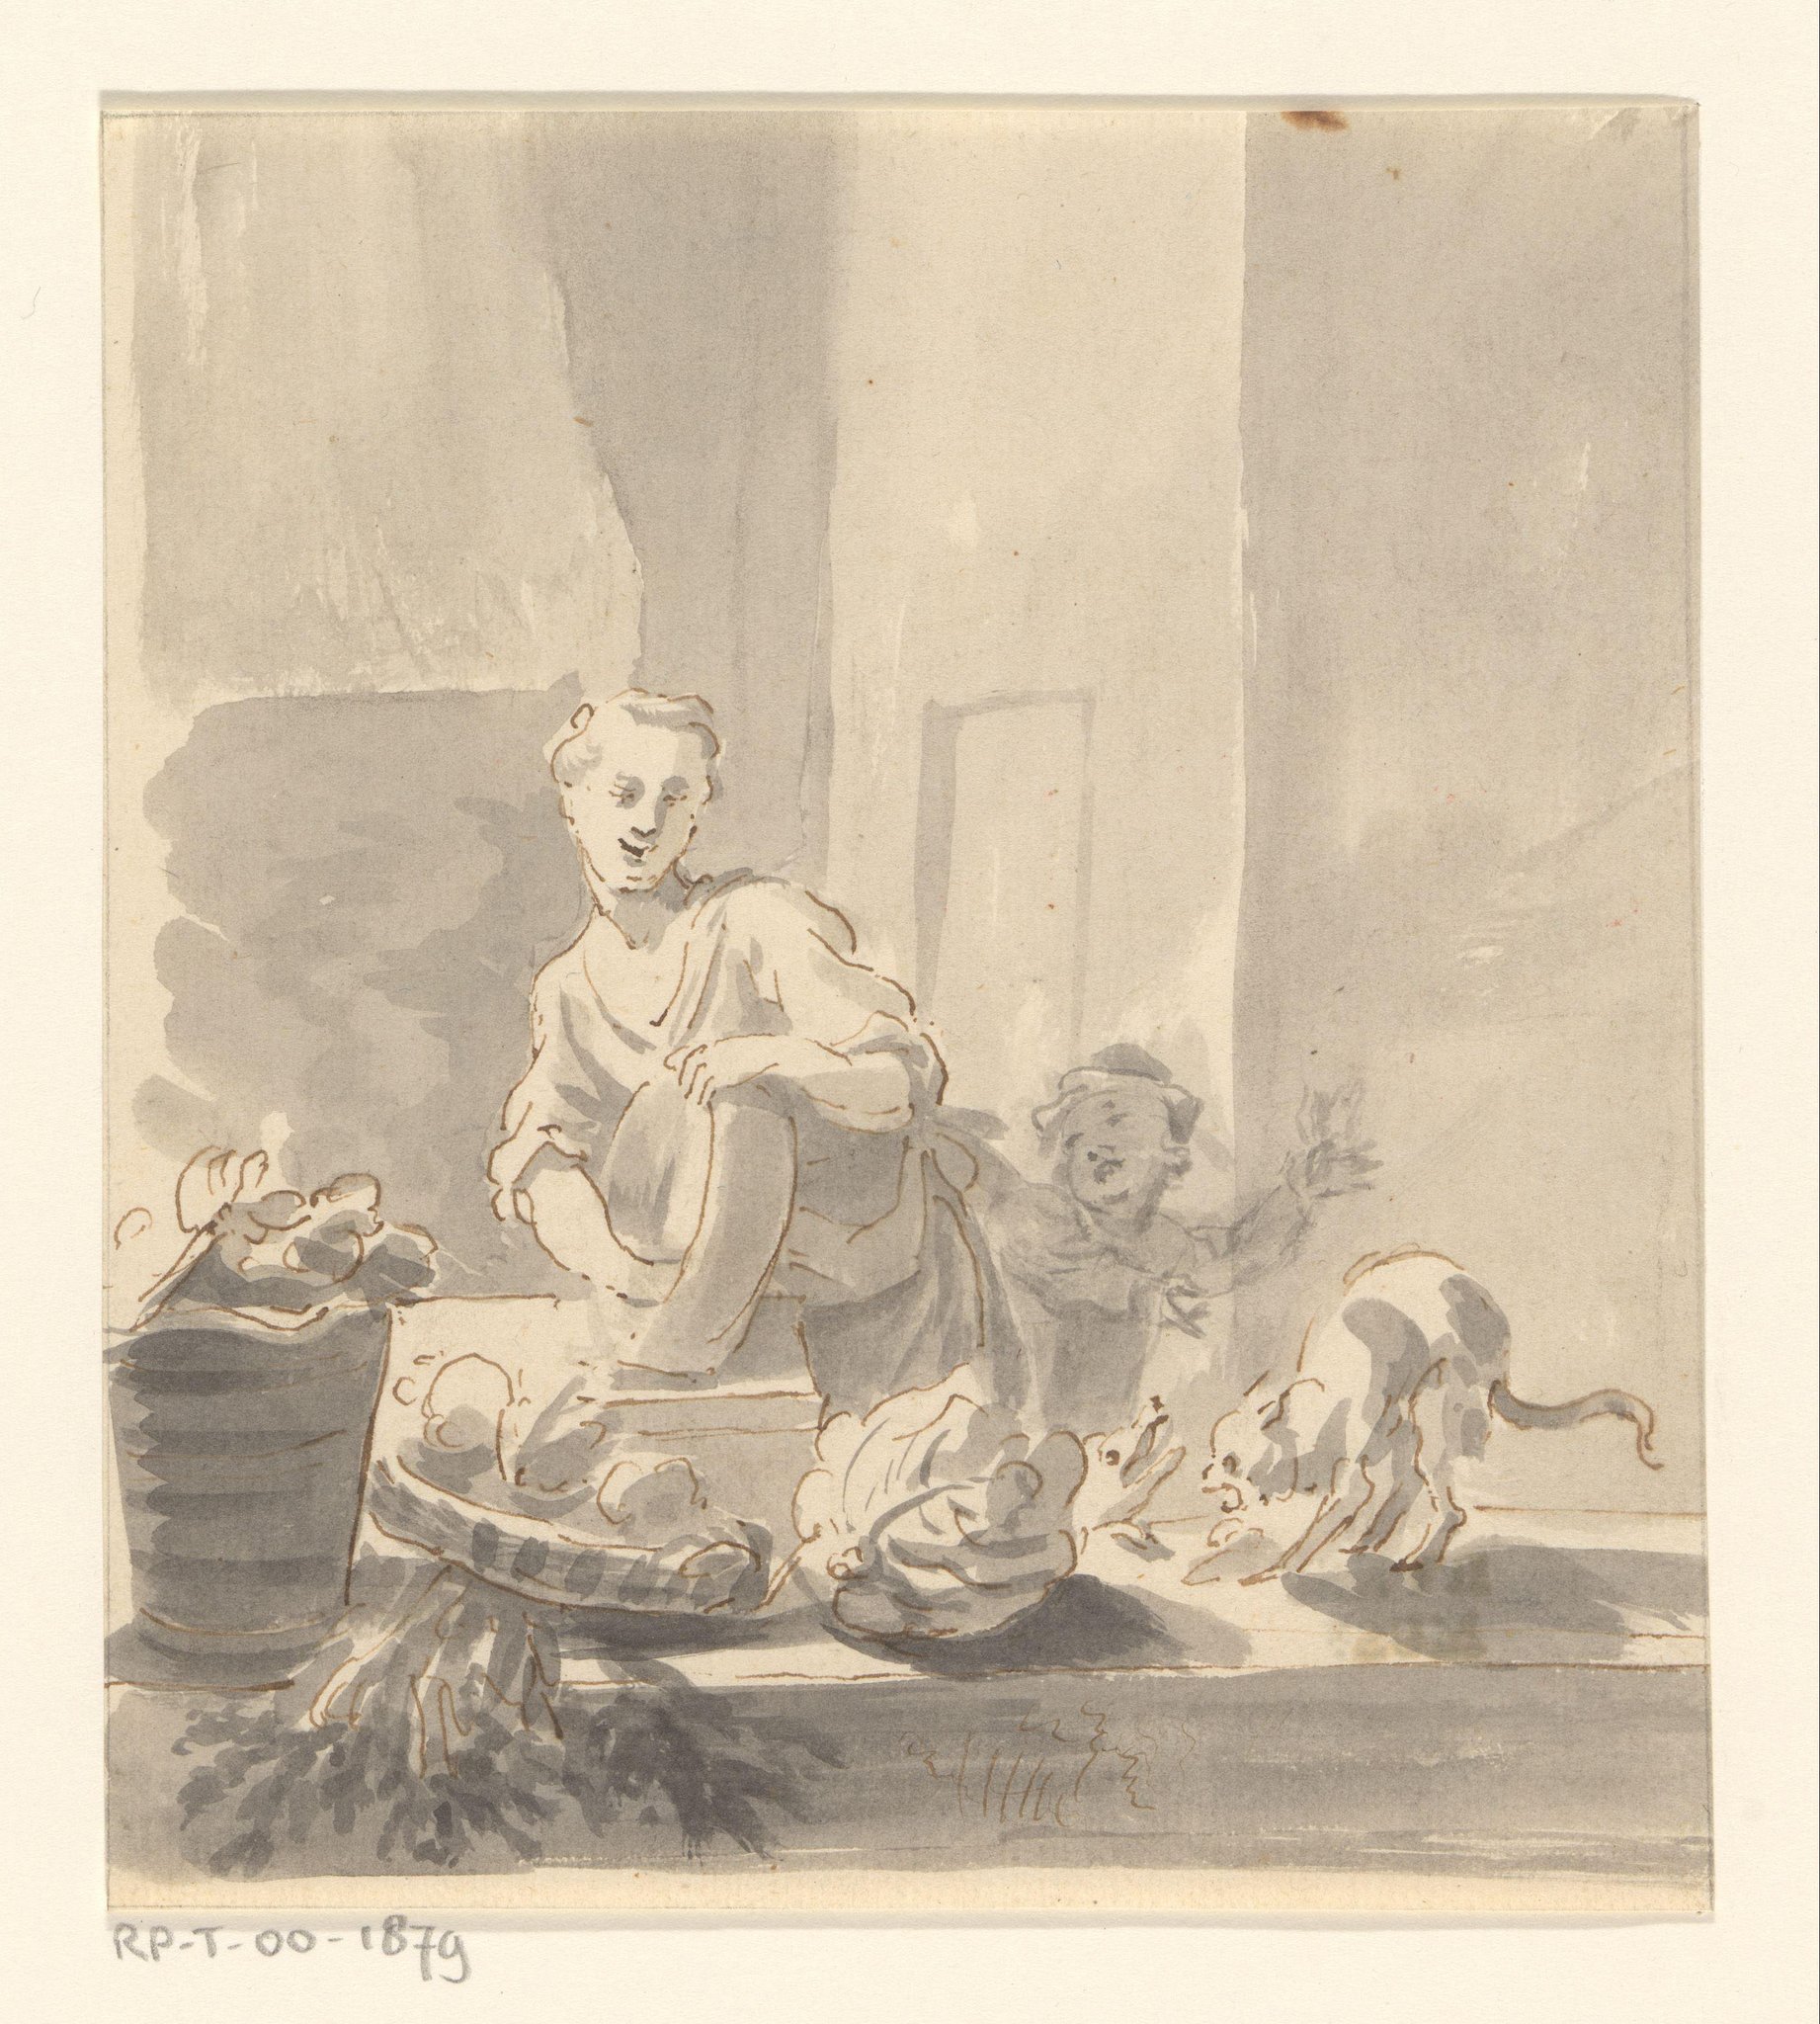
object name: drawing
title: Keukenstuk met poetsende meid, kind en vechtende hond en kat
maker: Anonymous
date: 1700-1800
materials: ink, paper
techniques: brush, pen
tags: kitchen-maid, kitchen servant, kitchen-interior with foodstuffs in foreground (dutch: 'keukenstuk')